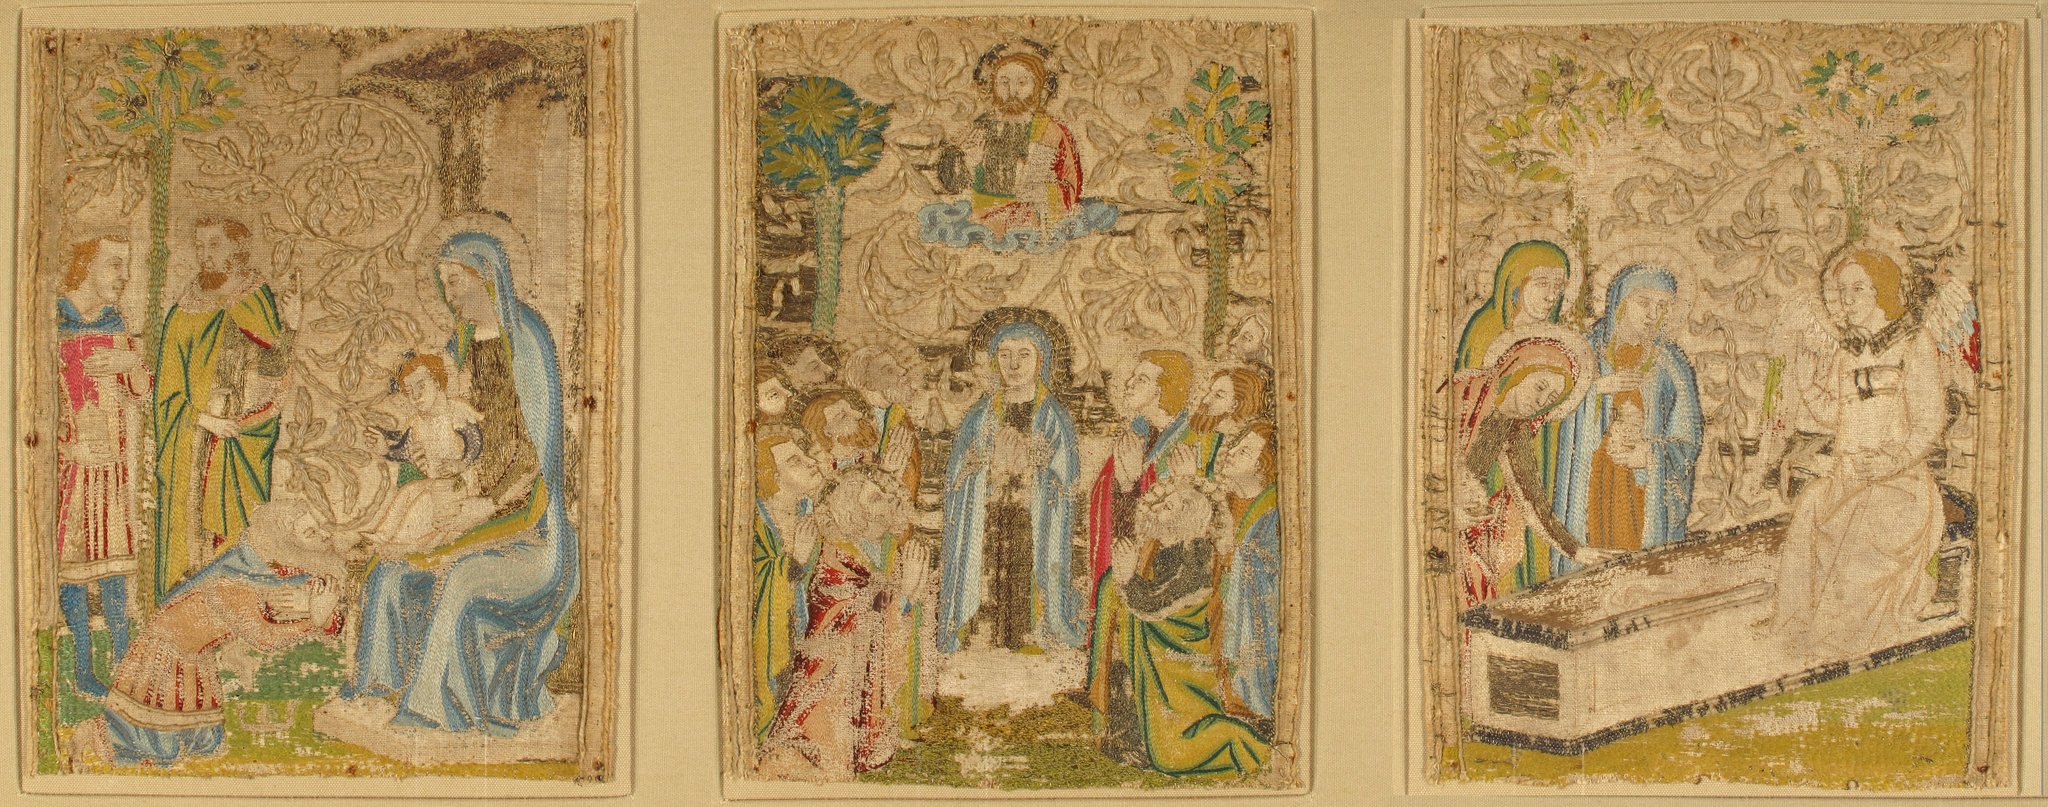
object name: panel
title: Three Panels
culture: italian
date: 1367-1400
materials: linen, metal thread, textile, silk, thread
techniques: embroidery, relief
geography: italy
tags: christ,madonna and child,adoration of the magi